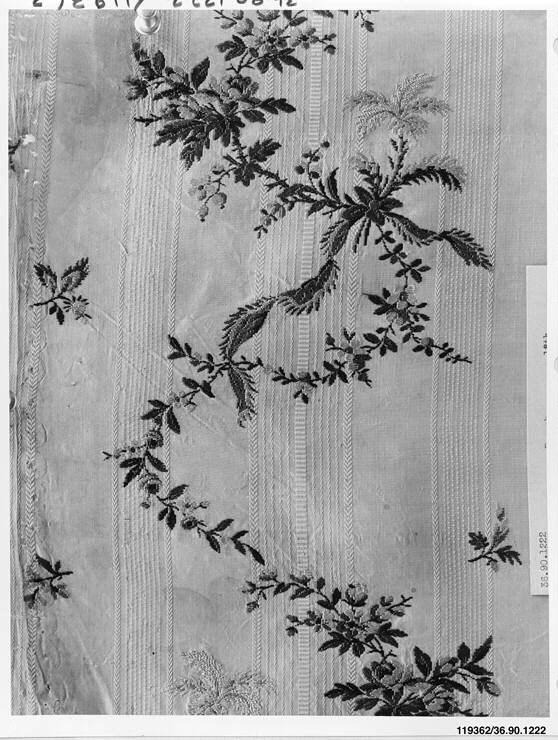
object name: piece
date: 1760-1770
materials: silk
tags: flowers,leaves